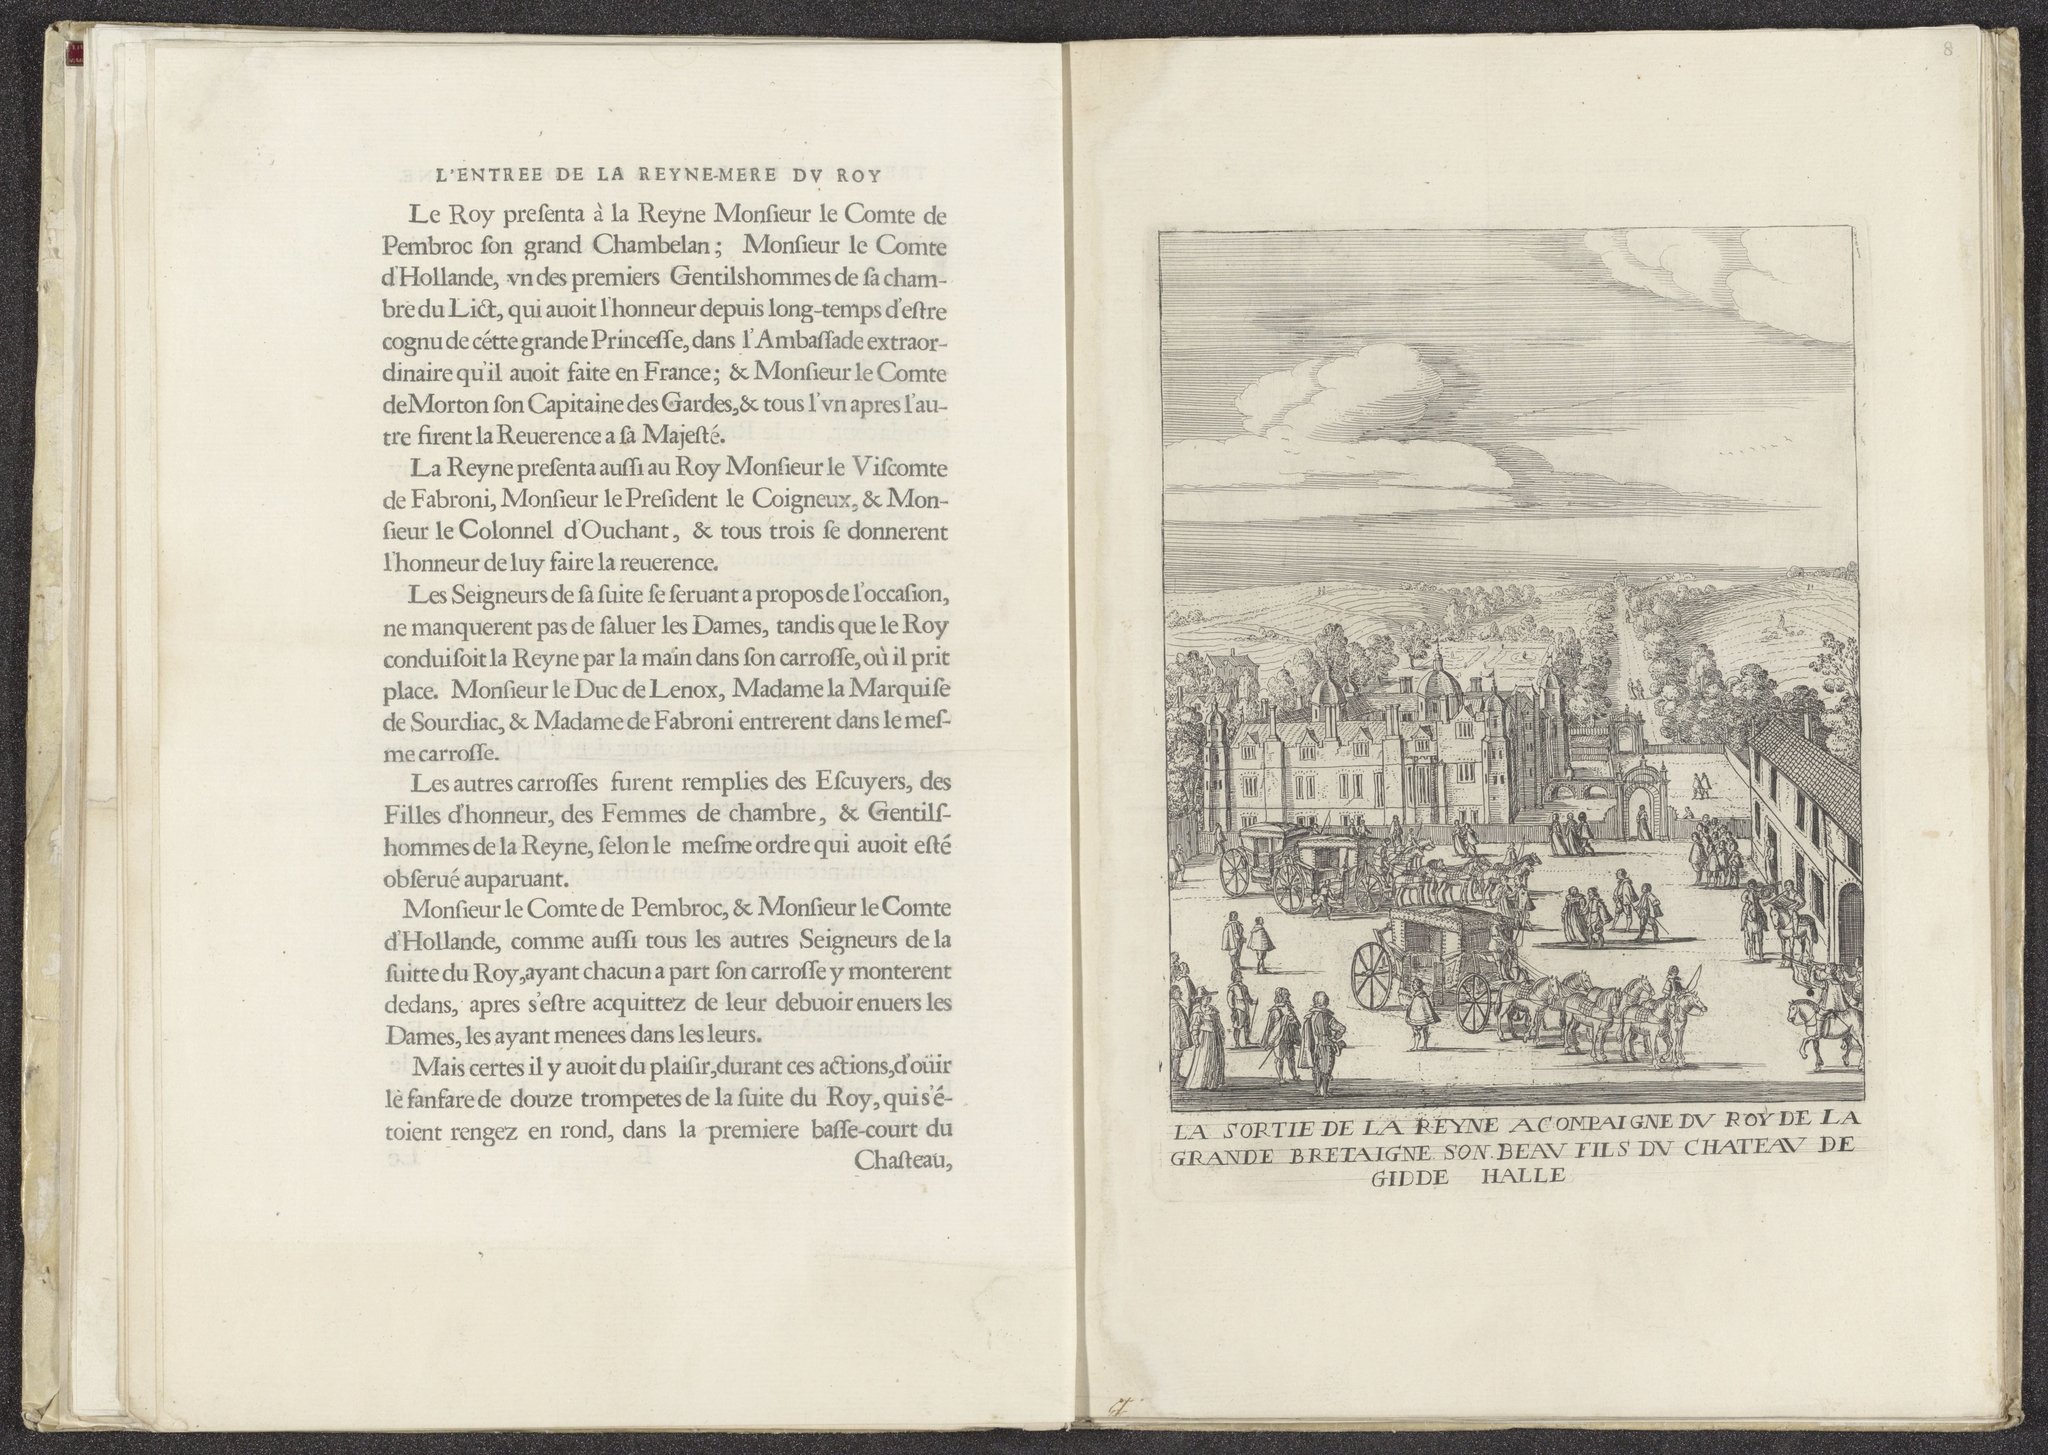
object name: history print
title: La sortie de la reyne a compaigne du roy de la grande Bretaigne son beau fils du chateau de Gidde Halle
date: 1639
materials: paper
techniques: etching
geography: london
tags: cologne, maria de' medici, karel i (koning van engeland)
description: Maria de' Medici en Karel I bij de Guildhall. Er staan drie koetsen en verschillende aanzienlijke personen kijken toe. Een tuin en velden in de verte. De prent maakt deel uit van een boek over de ontvangst van de Franse koning-moeder Maria de' Medici aan Engeland.